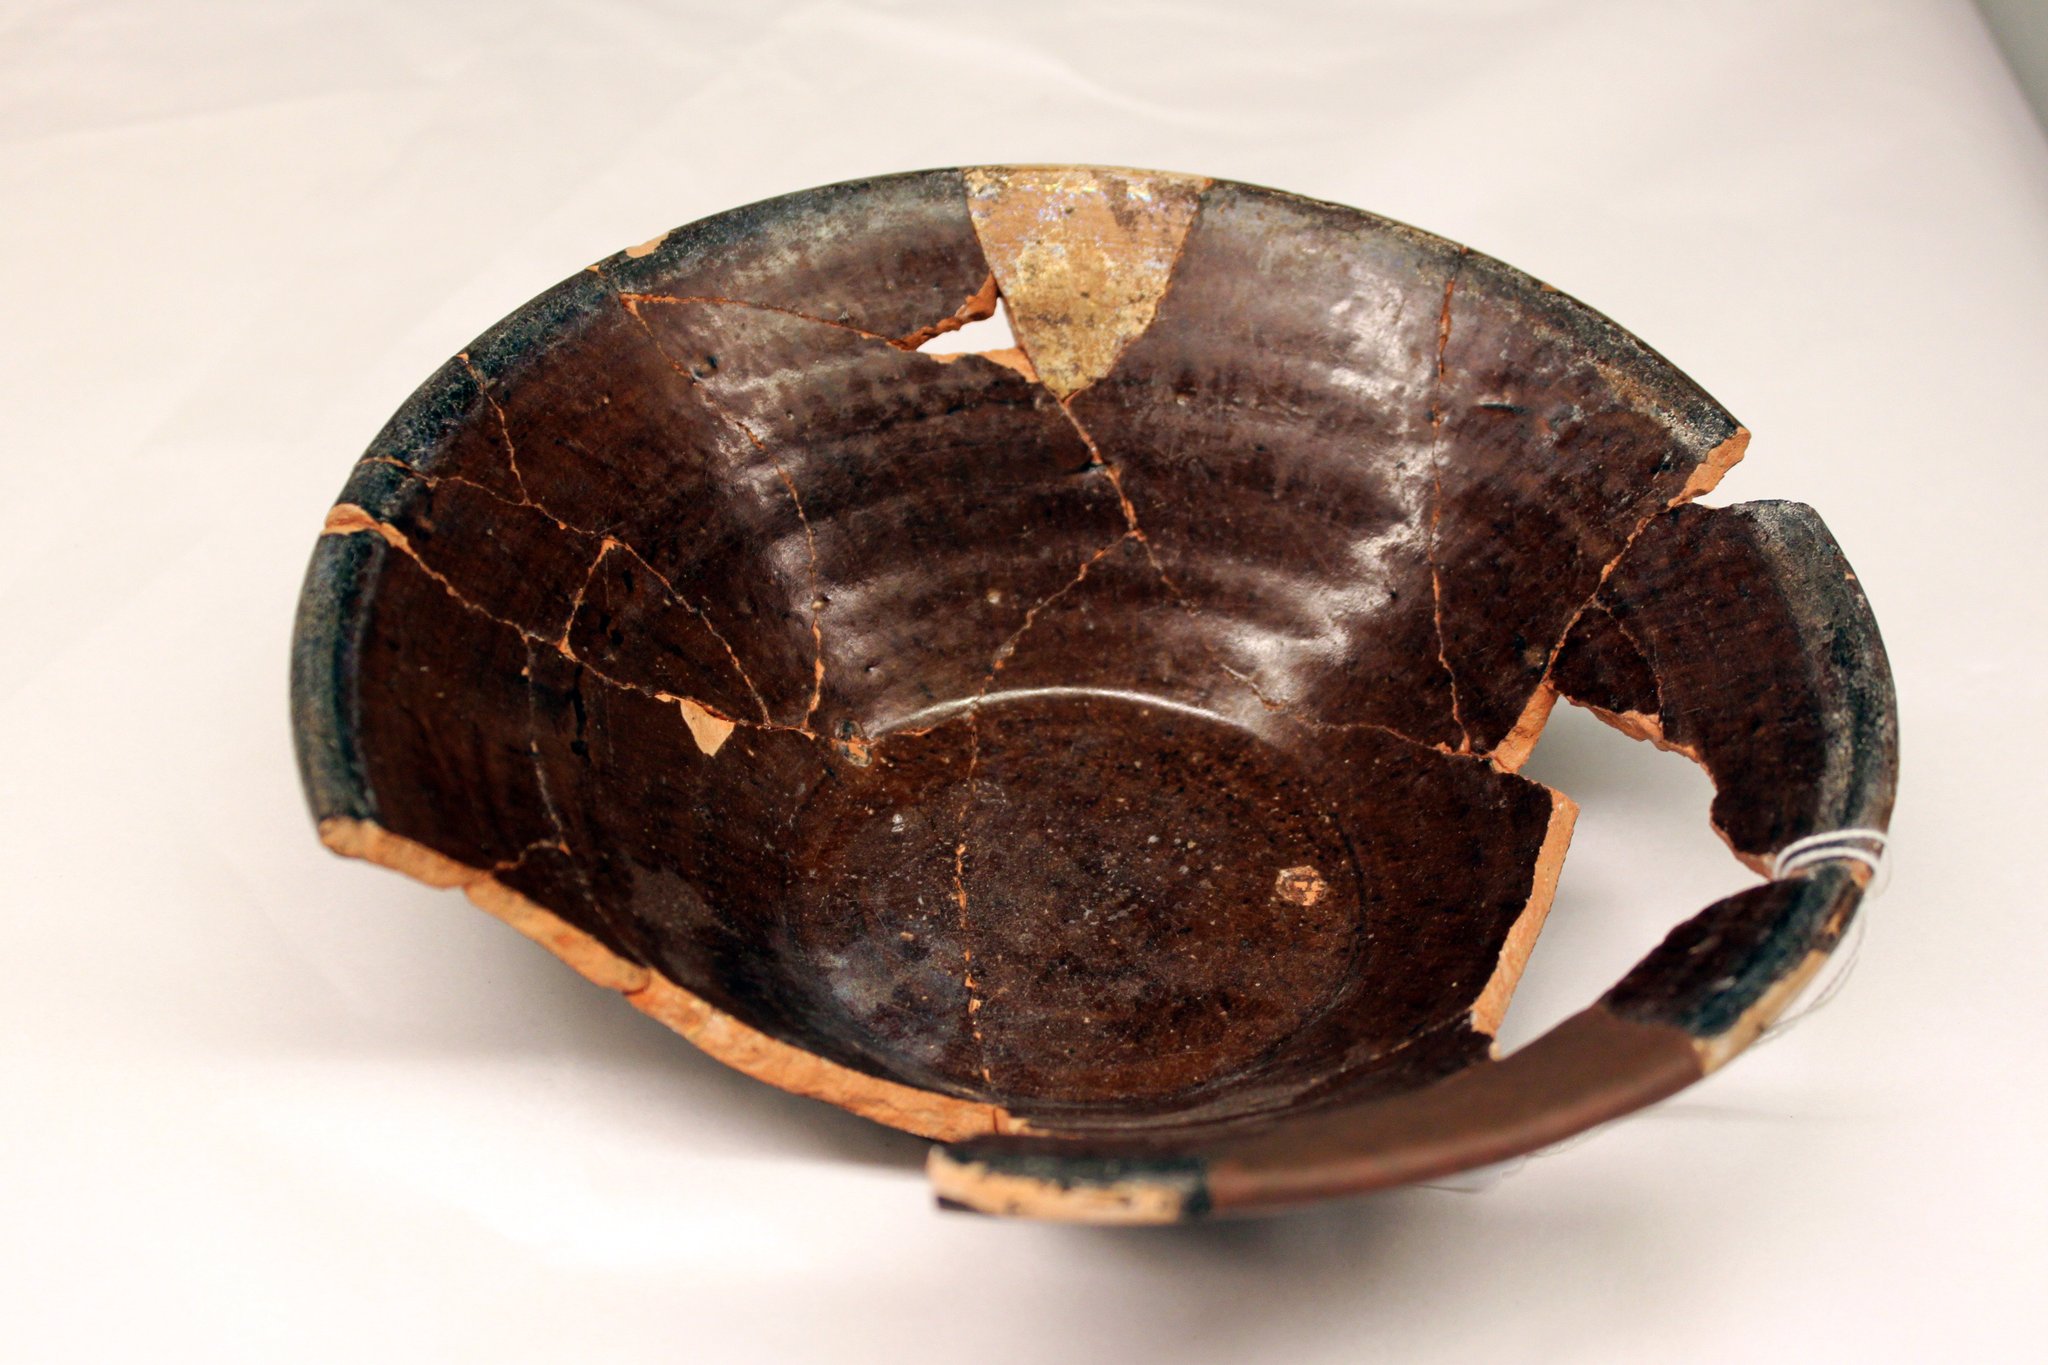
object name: bowl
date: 801-1000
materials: earthenware, glaze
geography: iran